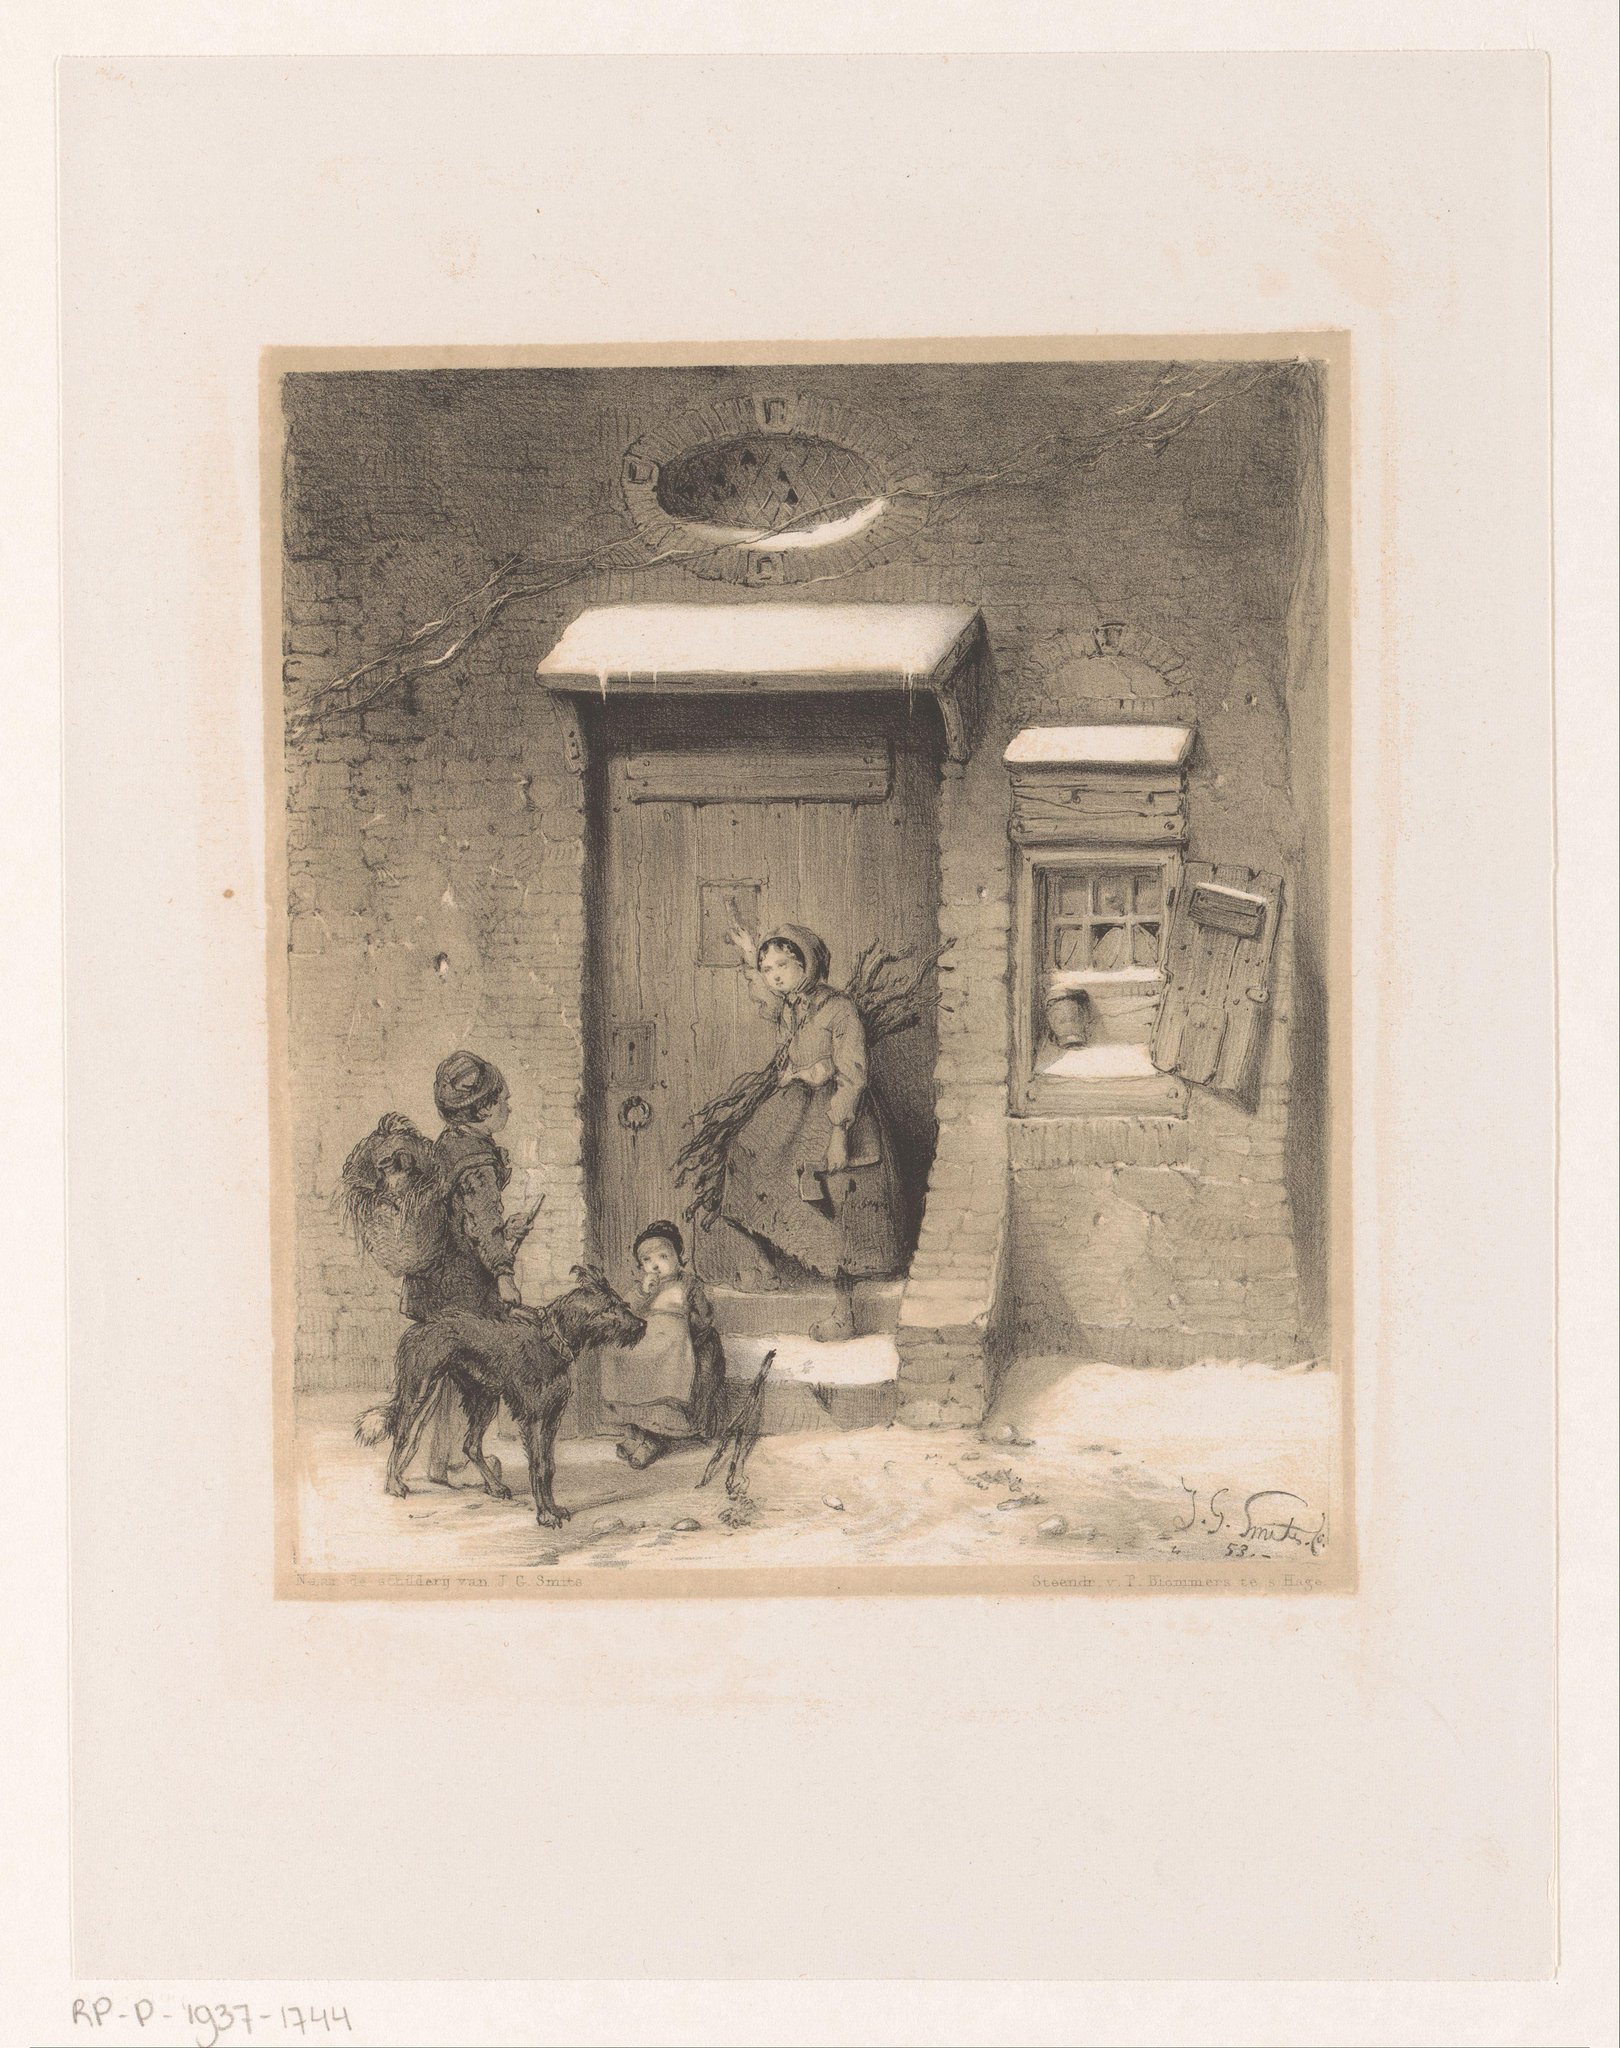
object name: print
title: Kinderen kloppen op buitendeur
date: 1853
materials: paper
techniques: tone lithography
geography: the hague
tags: knocking at the door, woodgathering, woodgatherer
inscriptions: collector's mark: Lugt 2760, collector's mark: Lugt 2228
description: Drie houtsprokkelende kinderen en hun hond bij een deur. Een meisje klopt aan.